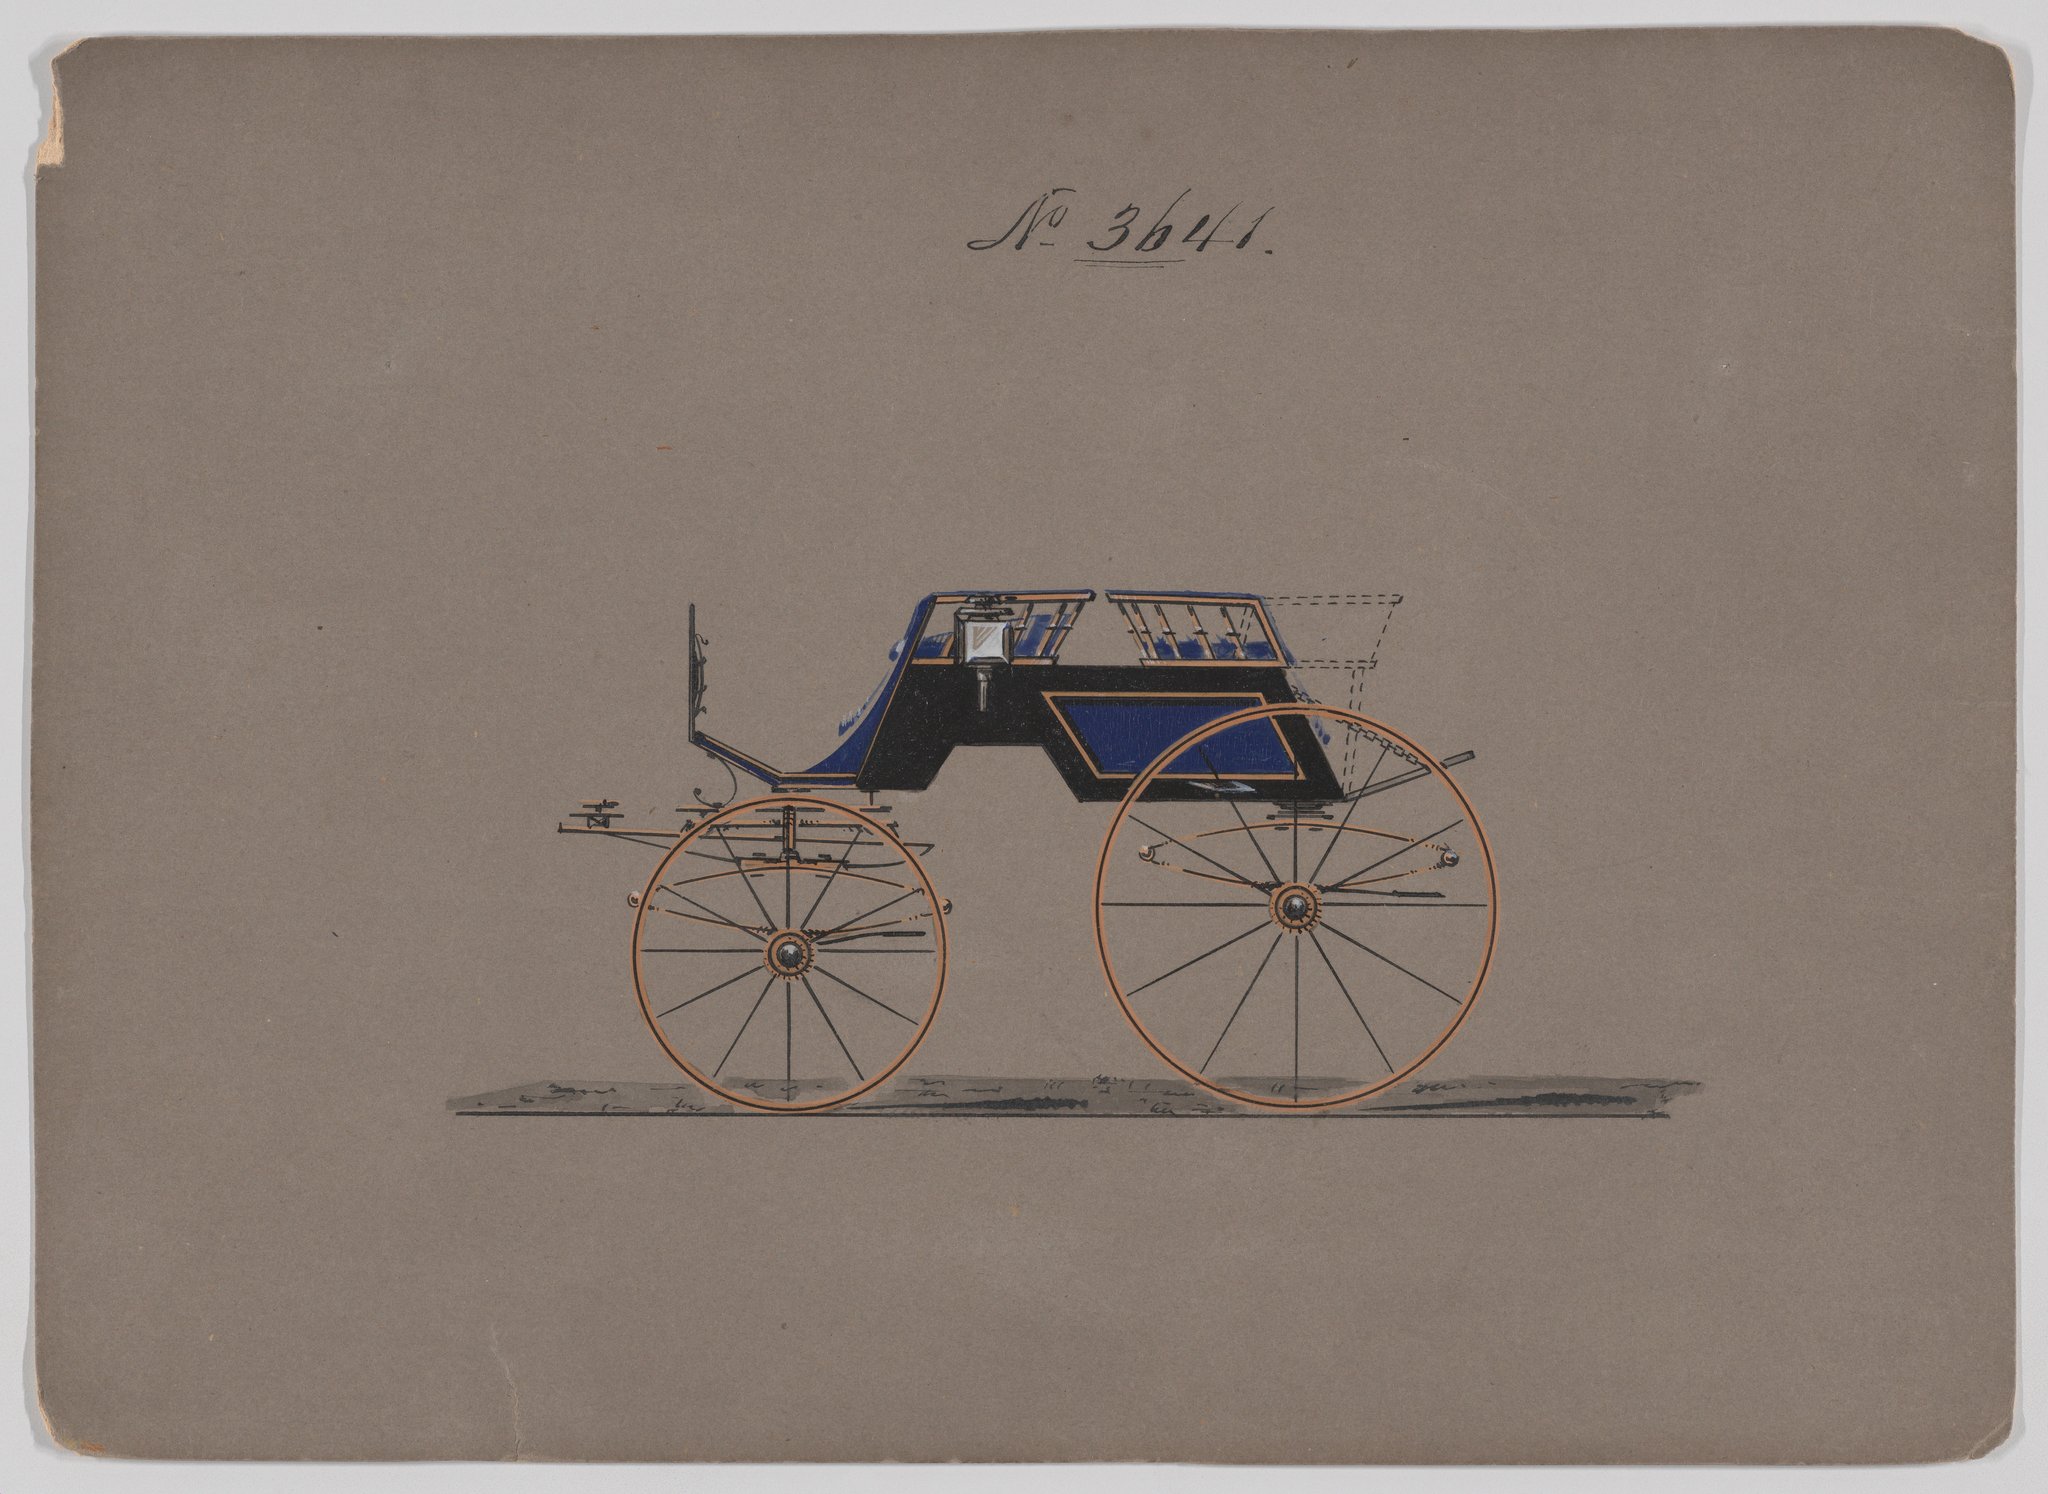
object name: drawing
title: Dog Cart/Shifting Seat Phaeton #3641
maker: brewster & co.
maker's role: manufacturer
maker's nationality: american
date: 1880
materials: gouache, gum arabic, ink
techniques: pen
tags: carriages